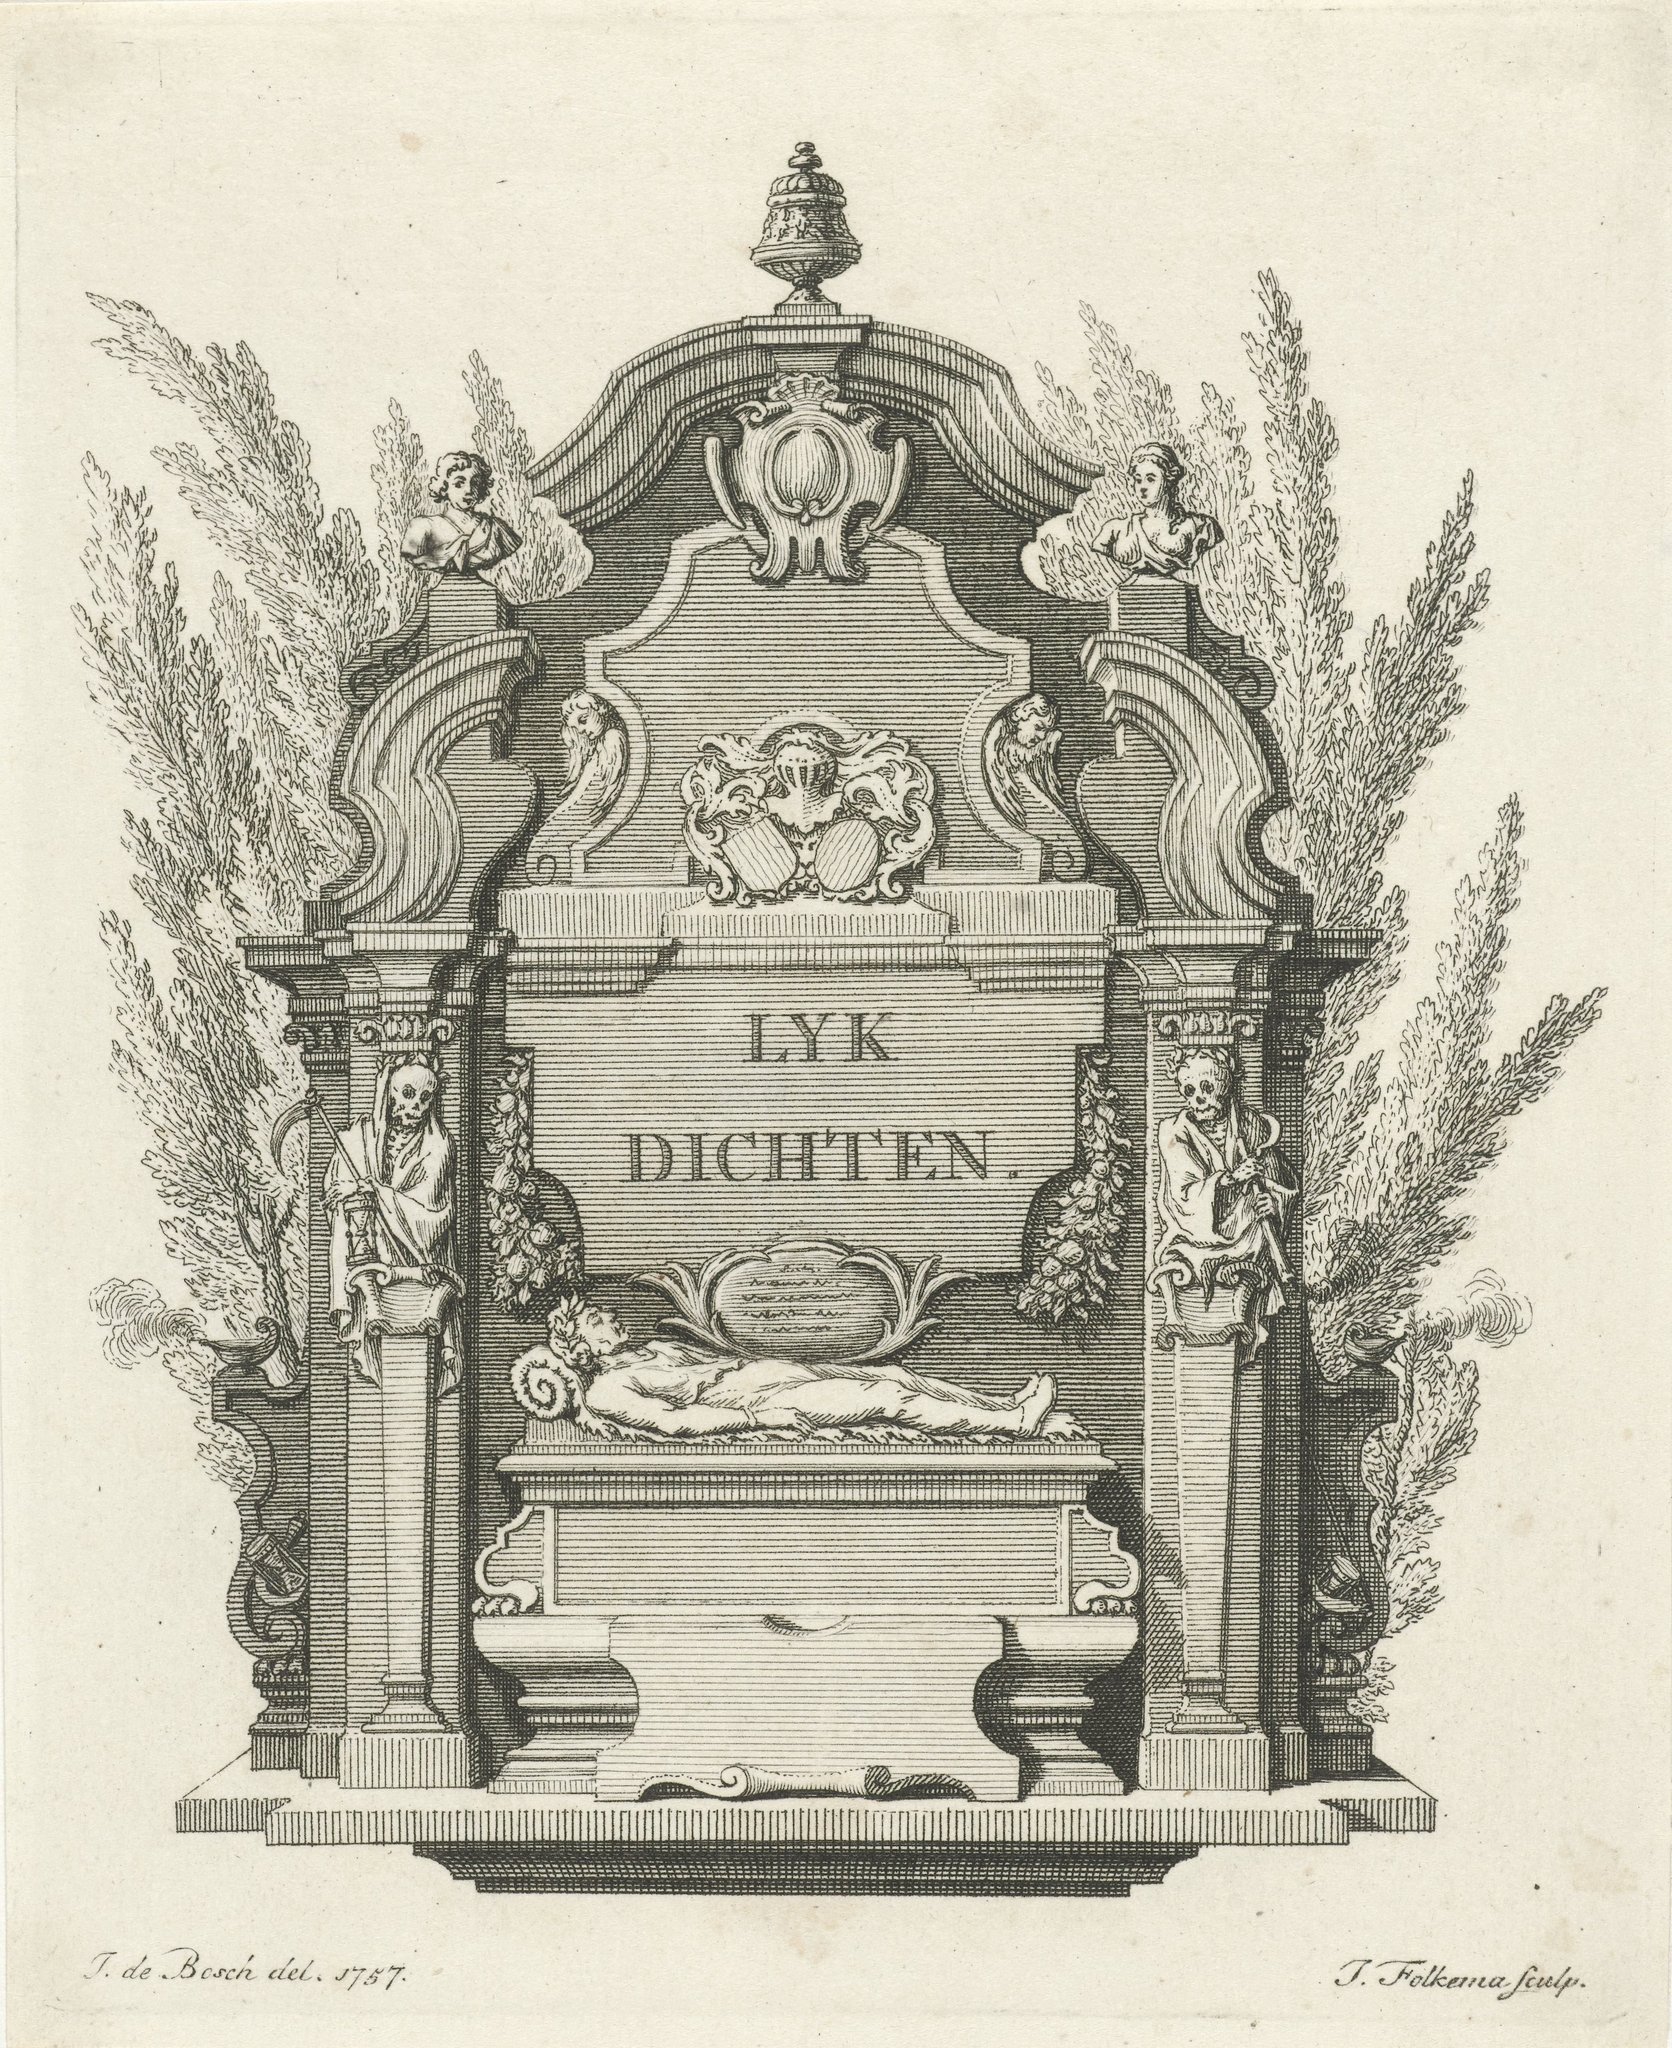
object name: print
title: Grafmonument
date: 1757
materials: paper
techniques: etching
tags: grave-building, monumental tomb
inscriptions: collector's mark: Lugt 2228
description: Grafmonument waar op de sarcofaag een beeld van de gelauwerde overledene ligt. Op de pilasters links en rechts van de sarcofaag prijken personificaties van de dood: skeletten, gehuld in kleden, met in de handen een zeis of sikkel, zandloper en een uitgedoofde toorts. Het epitaaf is versierd met de titel en twee wapenschilden. De lijst van het grafmonument is links en rechts getooid met portretbustes van een man en vrouw.